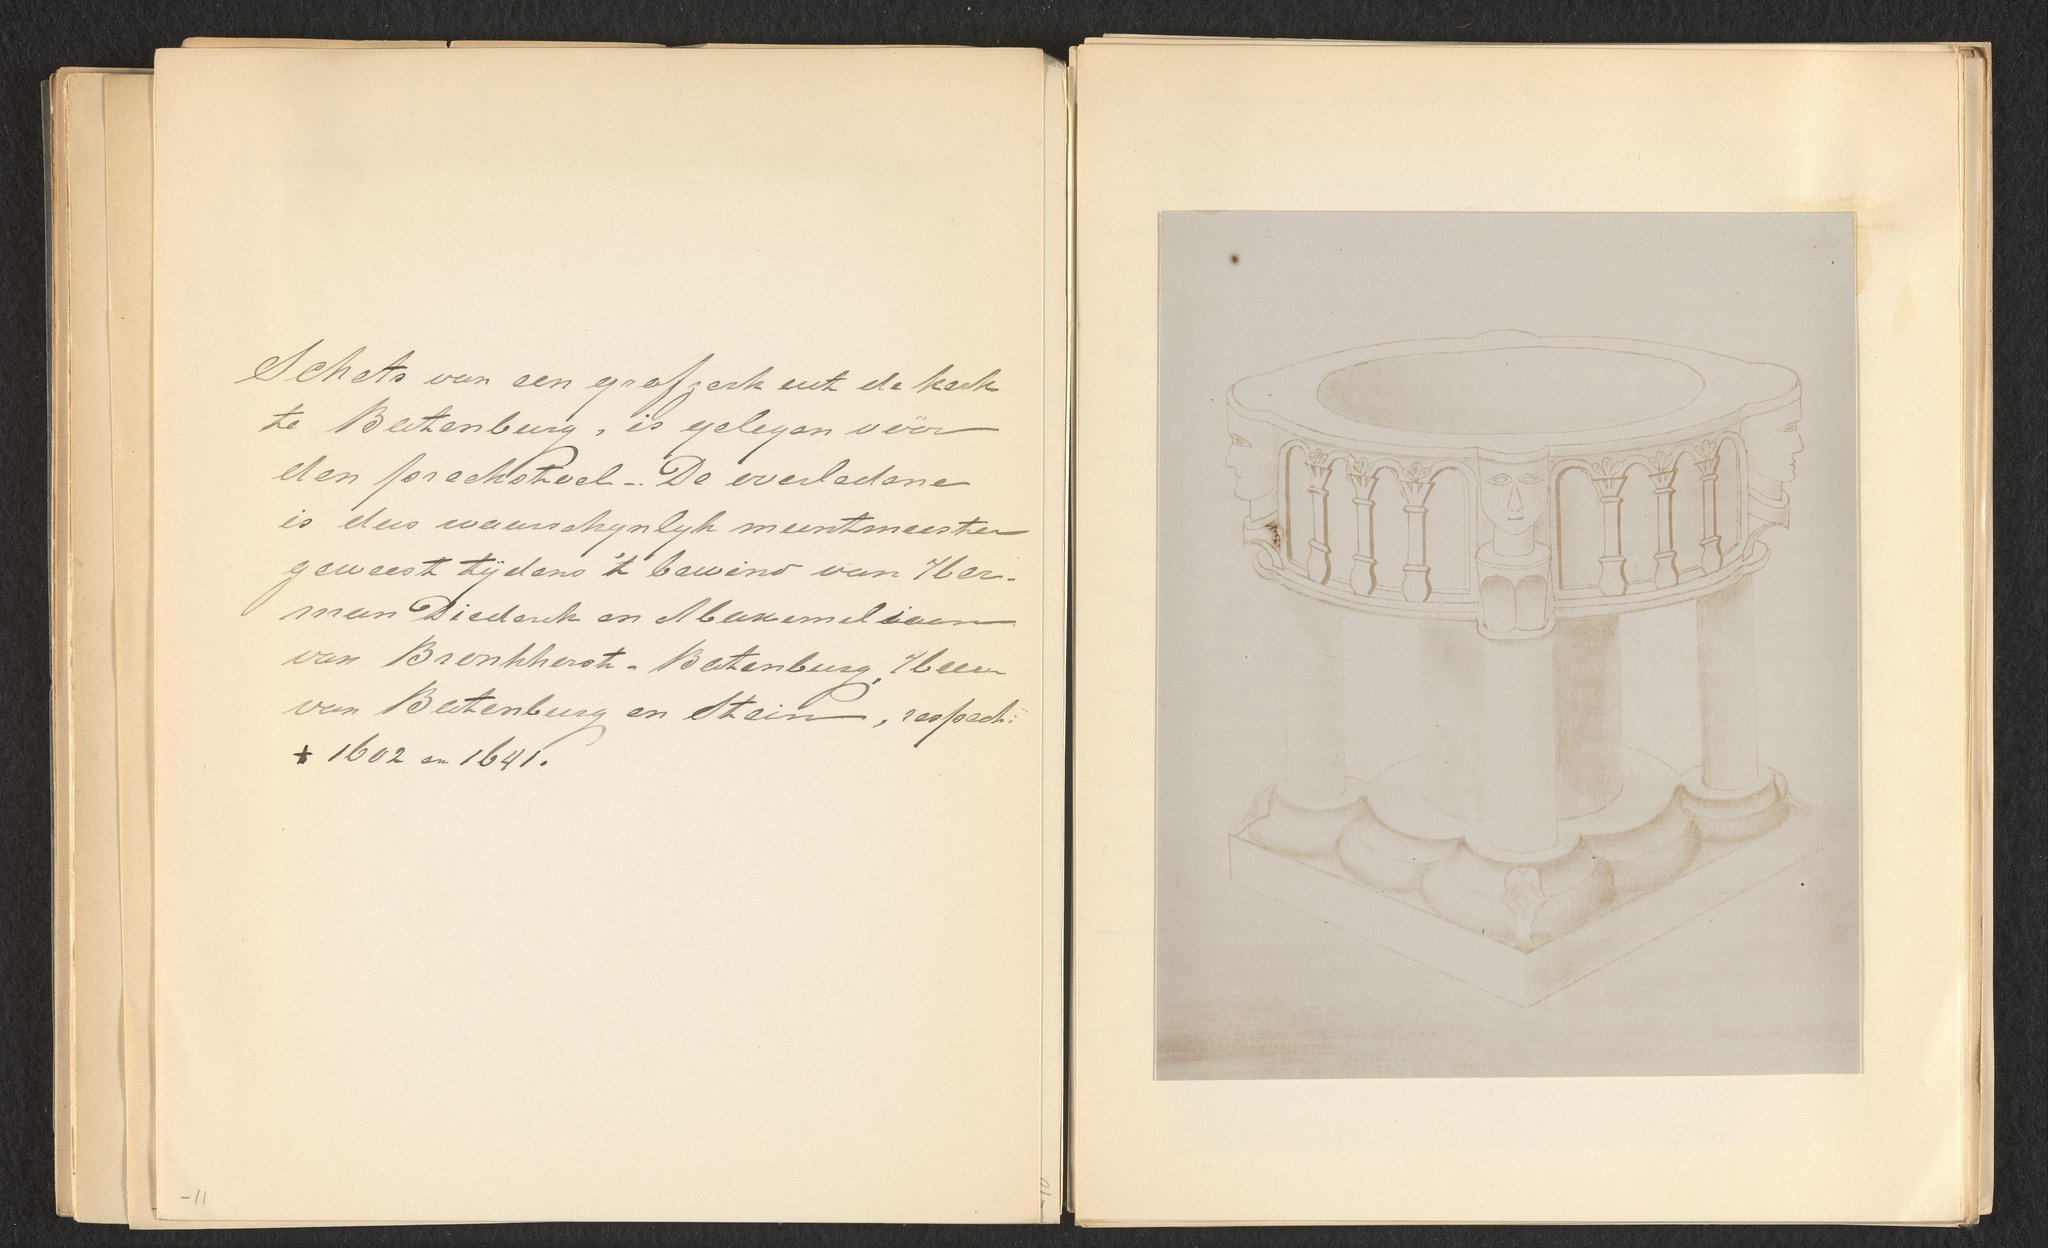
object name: reproduction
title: Fotoreproductie van een tekening van de doopvont in de Oude Sint-Victorkerk te Batenburg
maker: benjamin charlé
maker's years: 1845-1925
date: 1903-1908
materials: paper, cardboard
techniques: collodion silver print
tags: baptismal font